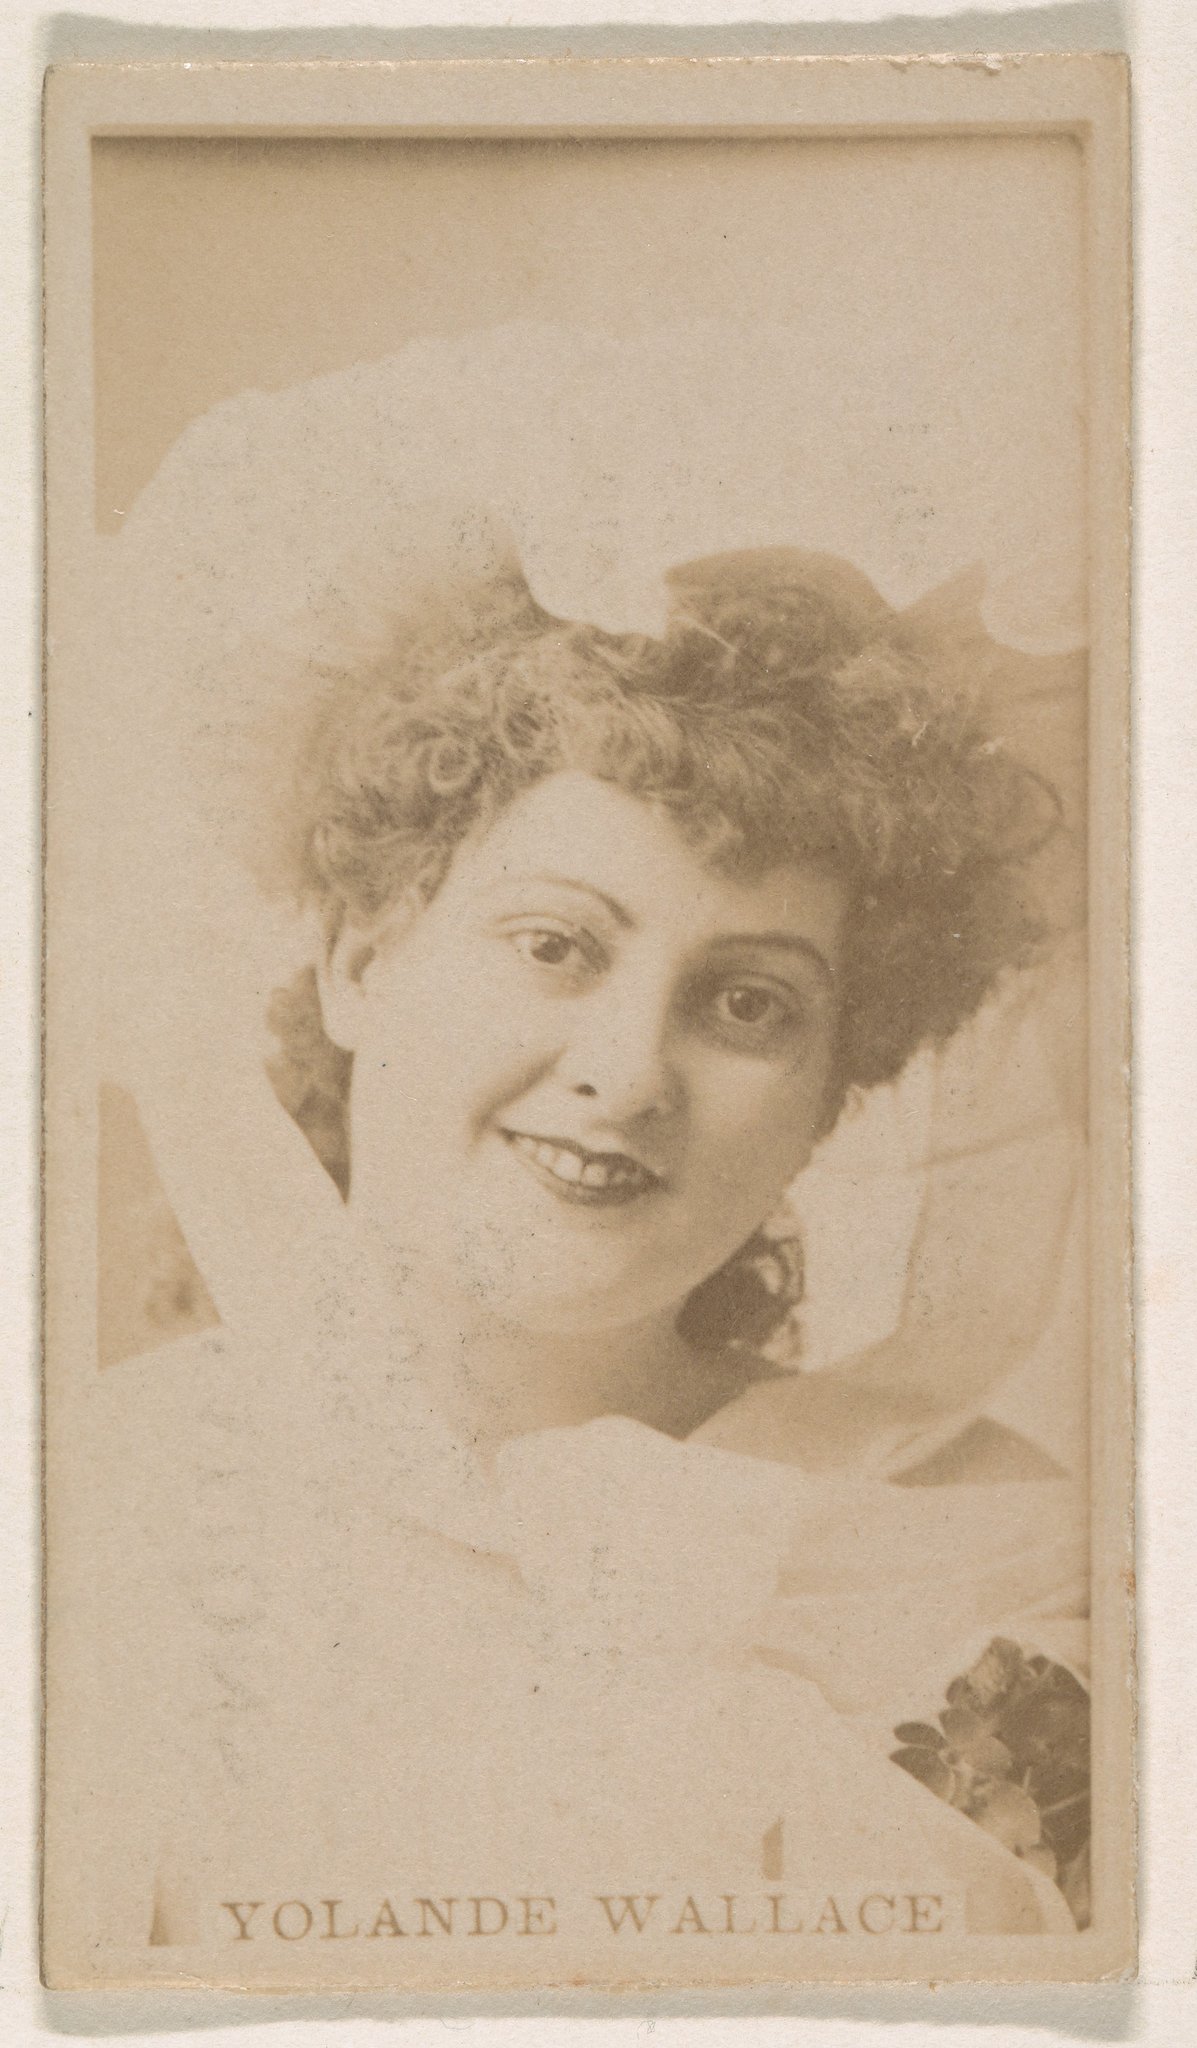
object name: photograph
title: Yolande Wallace, from the Actresses series (N245) issued by Kinney Brothers to promote Sweet Caporal Cigarettes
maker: kinney brothers tobacco company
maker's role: publisher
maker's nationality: american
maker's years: 1869-2011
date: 1890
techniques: albumen silver print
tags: portraits,women,actresses